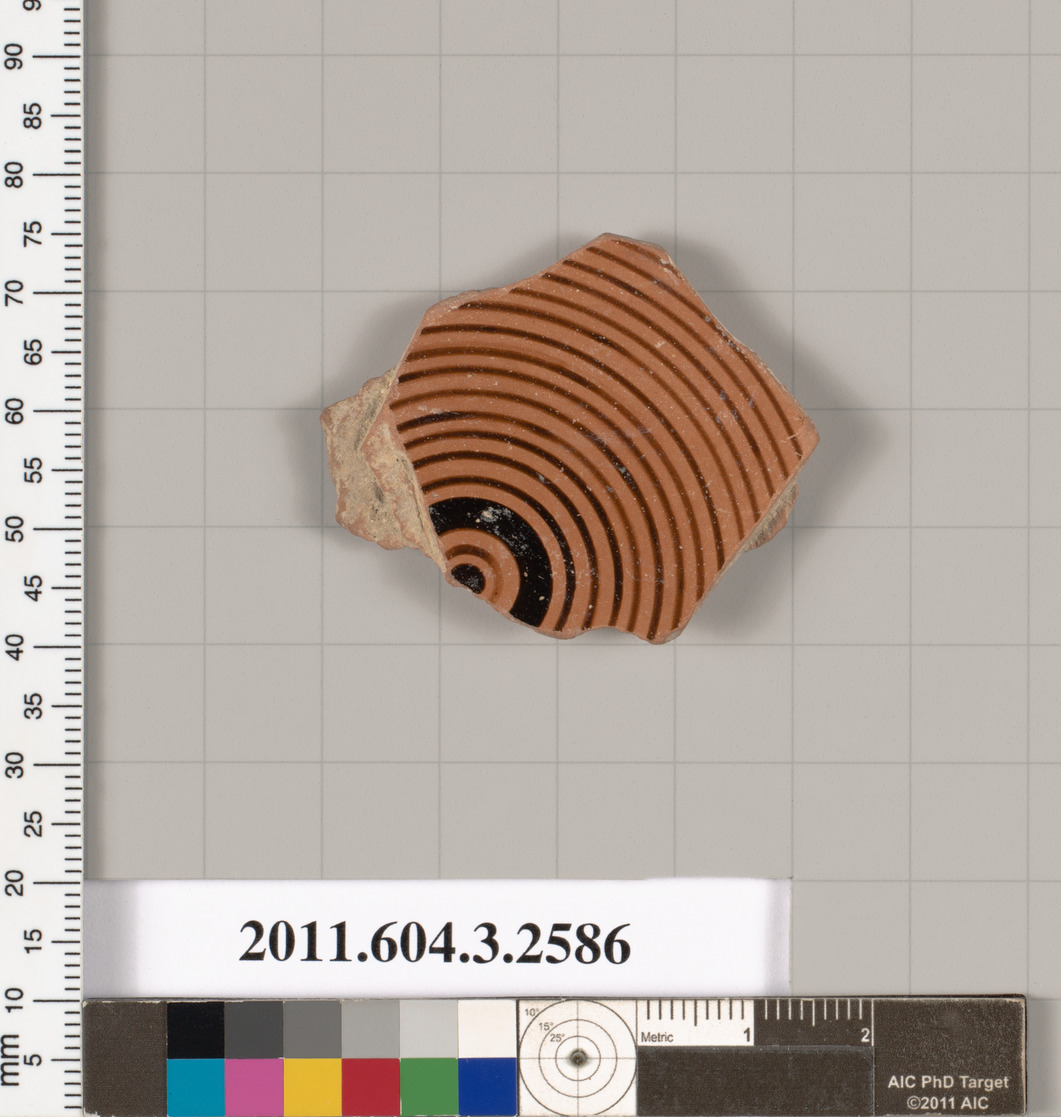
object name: kylix fragment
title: Terracotta fragment of a Little Master cup (drinking cup)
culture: greek, attic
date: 575-551 BCE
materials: terracotta